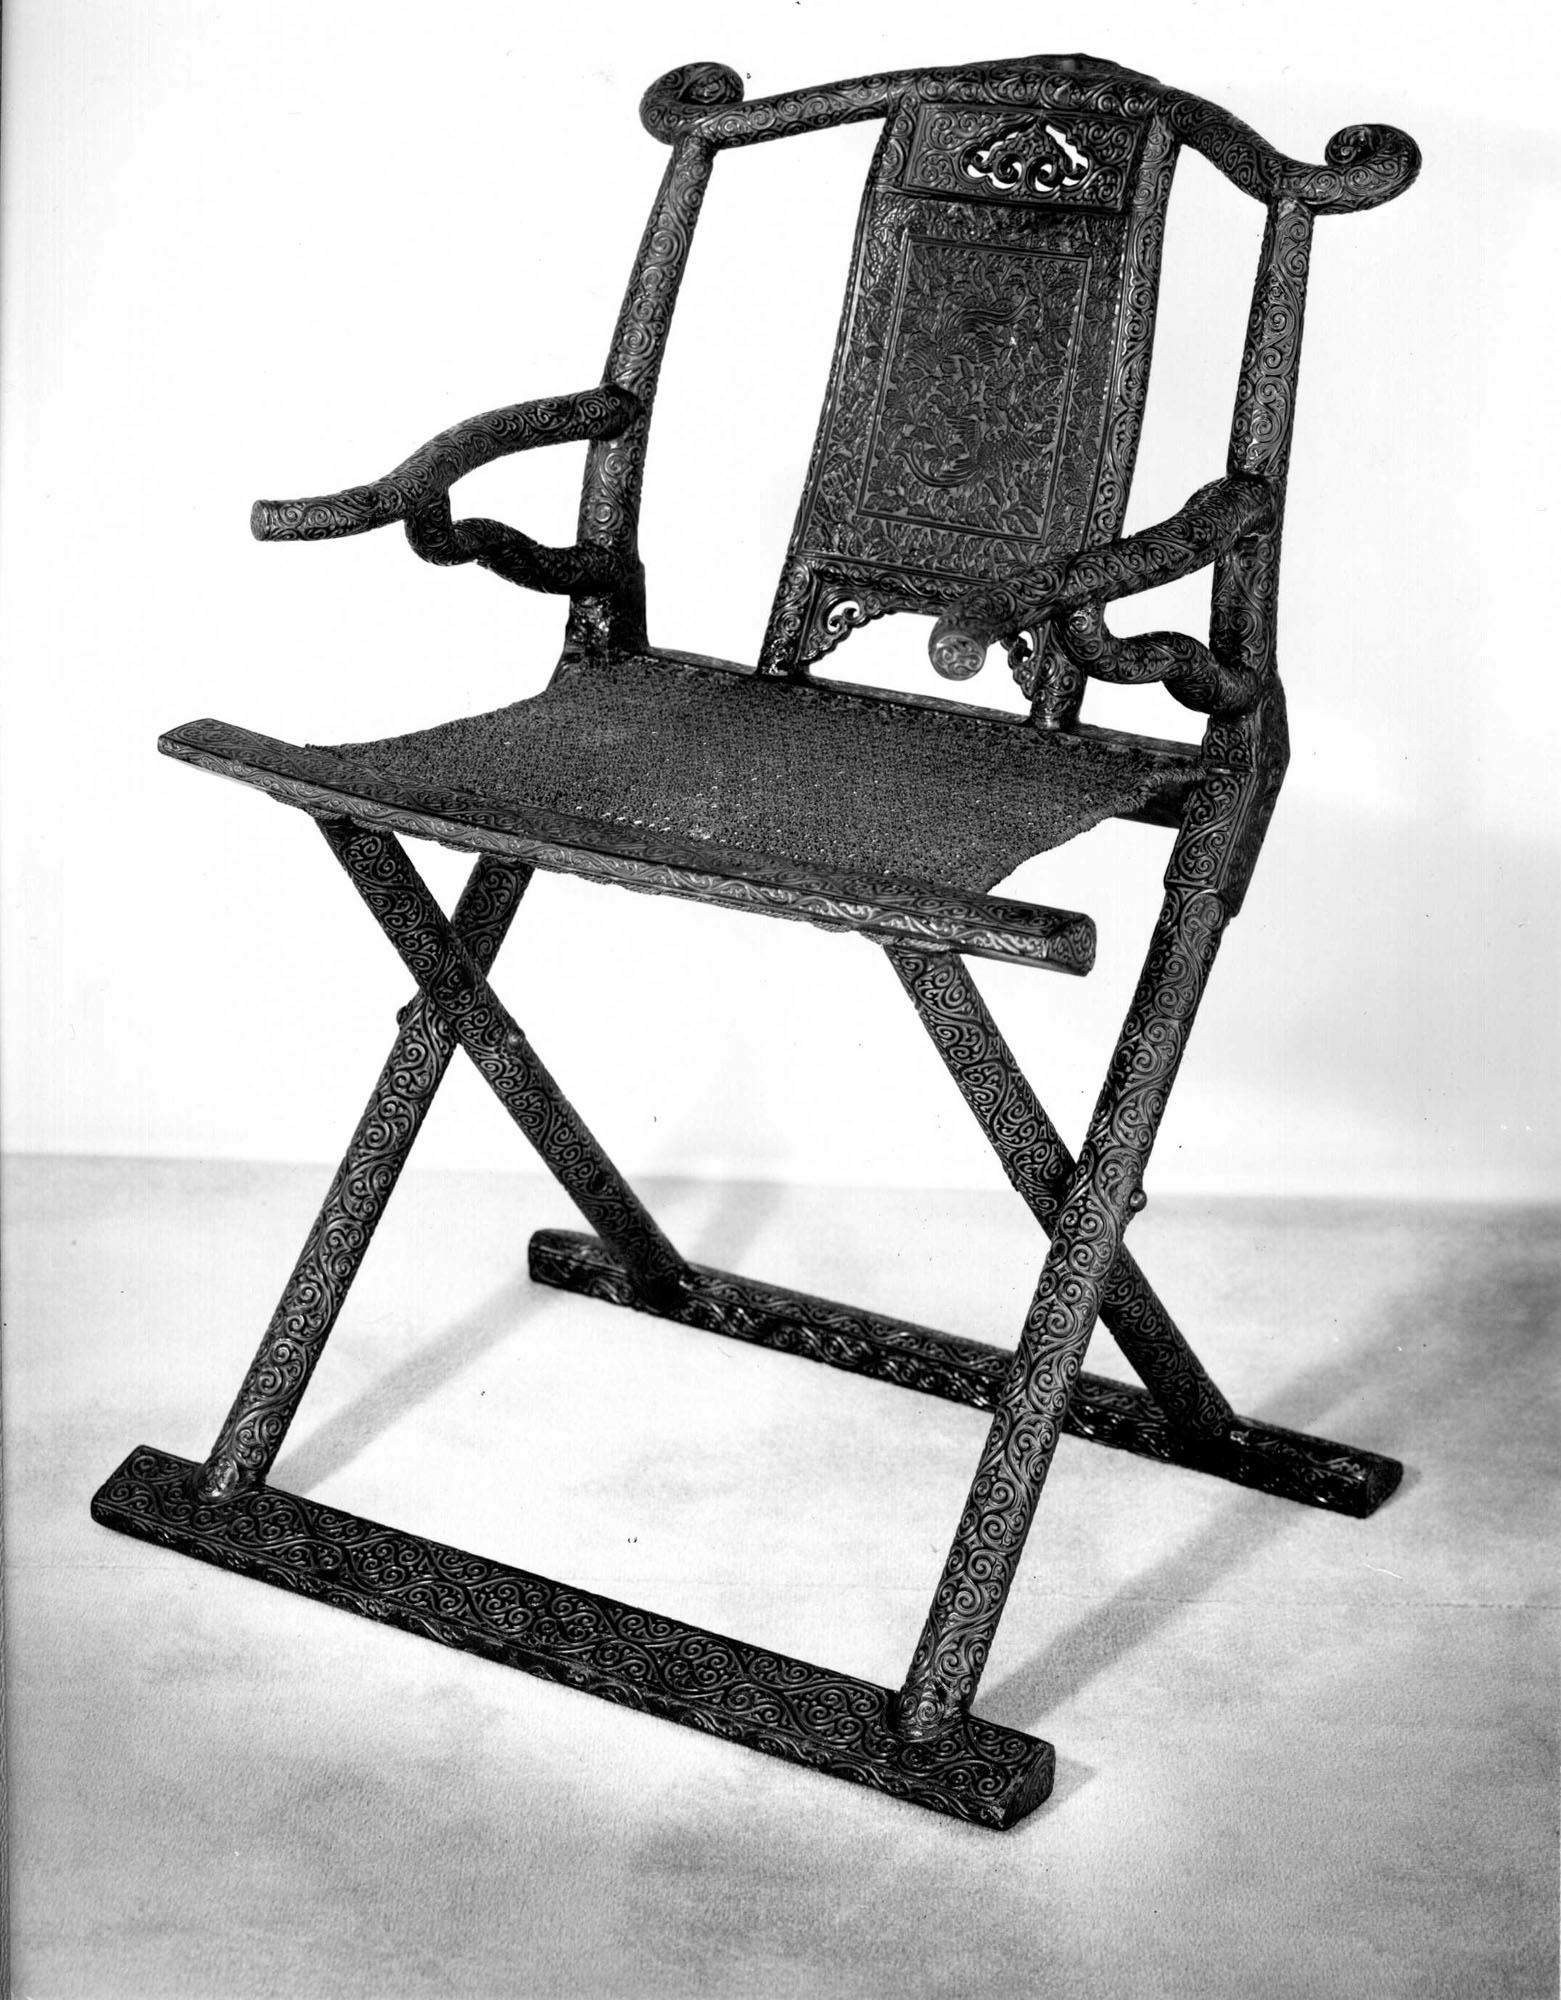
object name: folding chair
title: Folding chair with two birds among flowers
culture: chinese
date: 1201-1400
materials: lacquer, rattan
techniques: carving